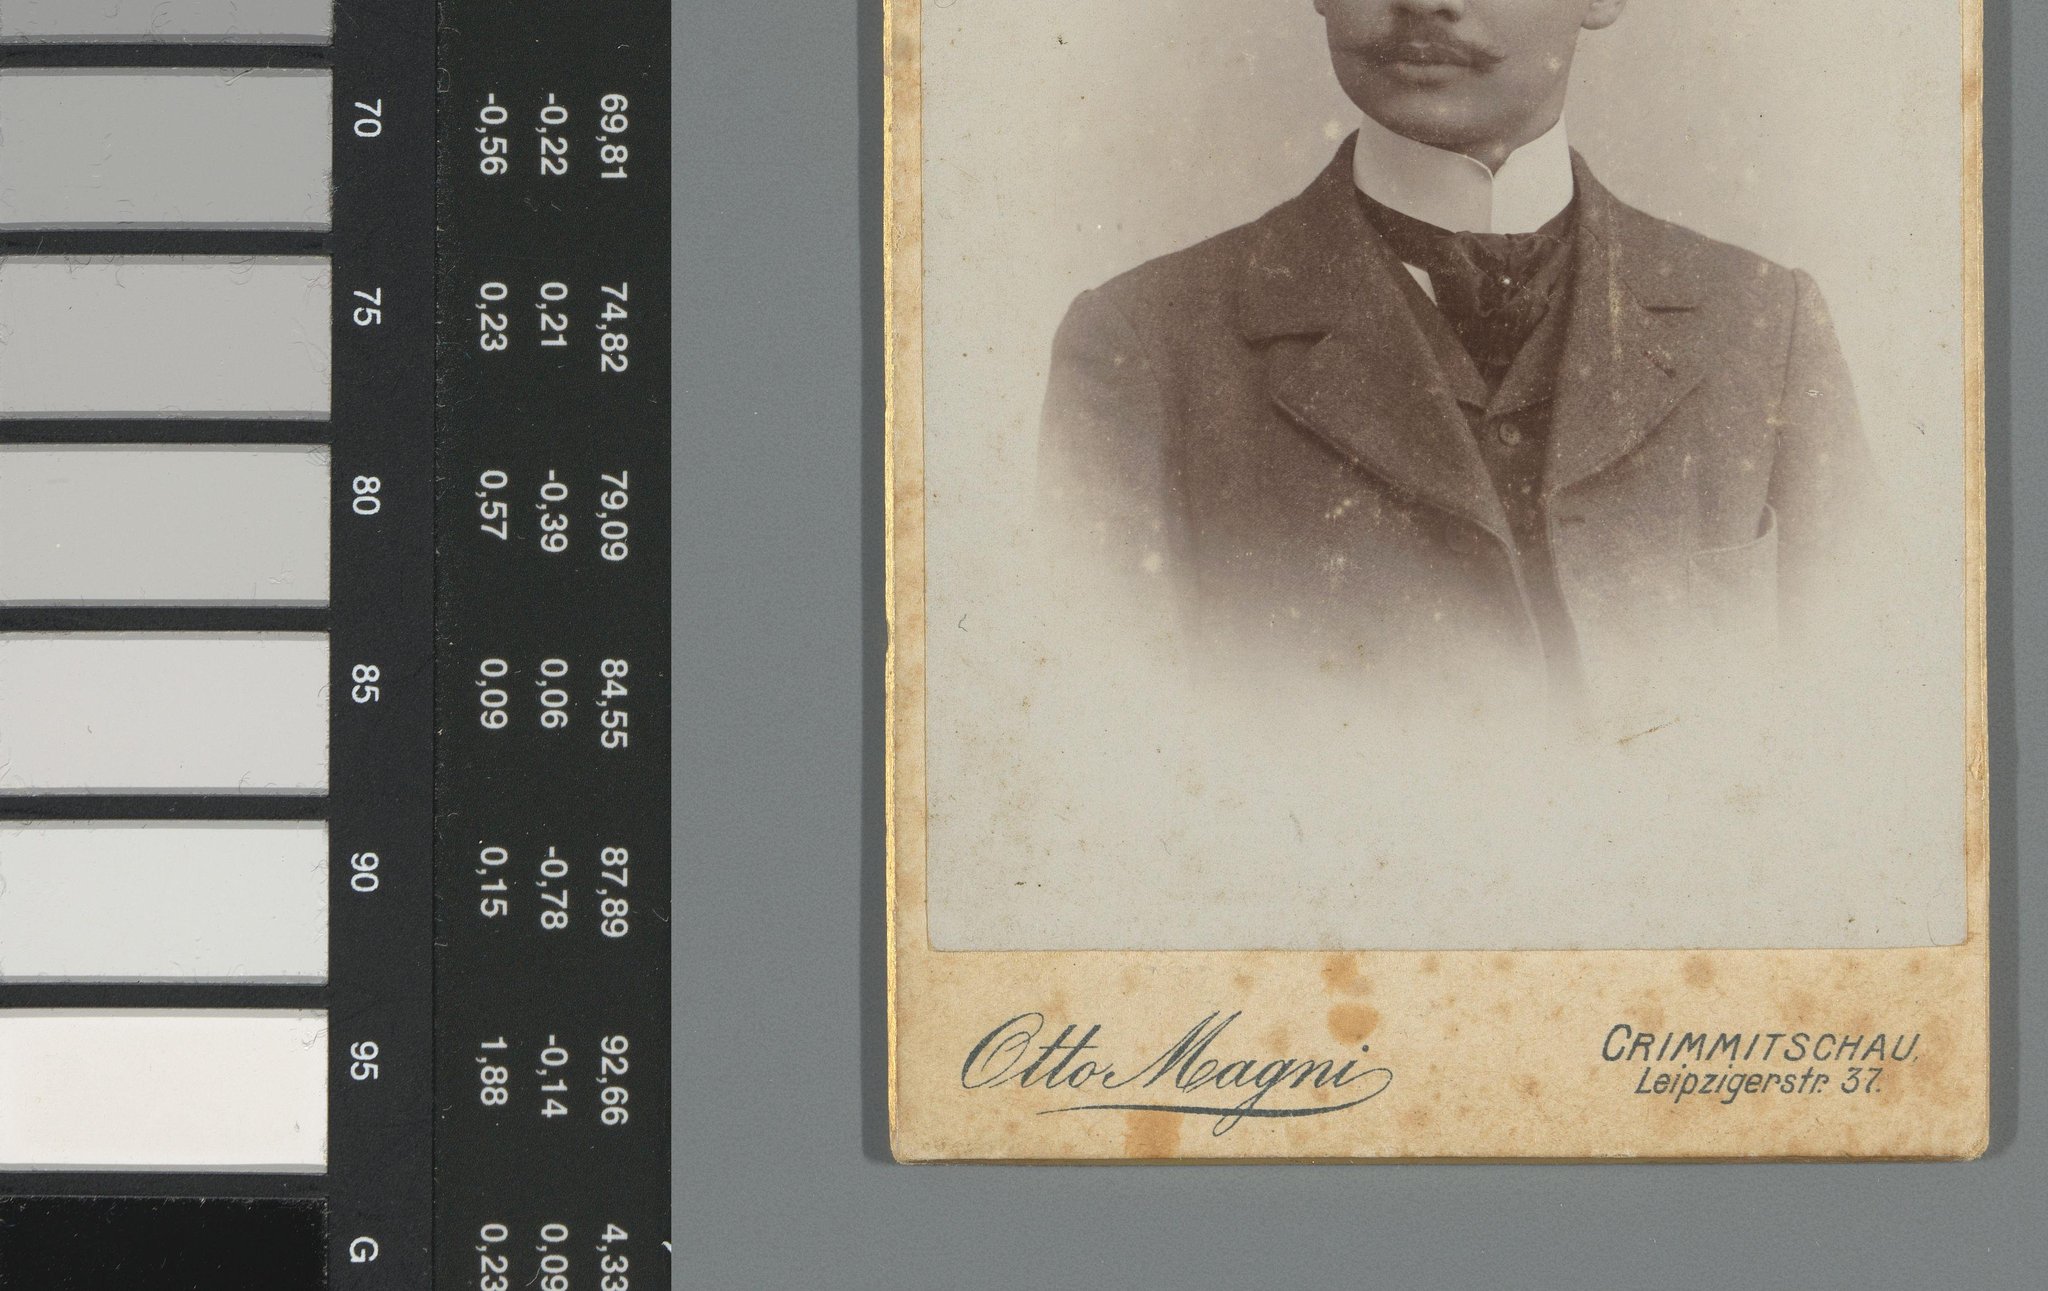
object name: carte de visite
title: Portret van een man, mogelijk Tonnie Dumas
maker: otto magni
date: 1901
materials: cardboard, photographic support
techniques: collodion silver print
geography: germany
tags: historical persons not known by name, germany